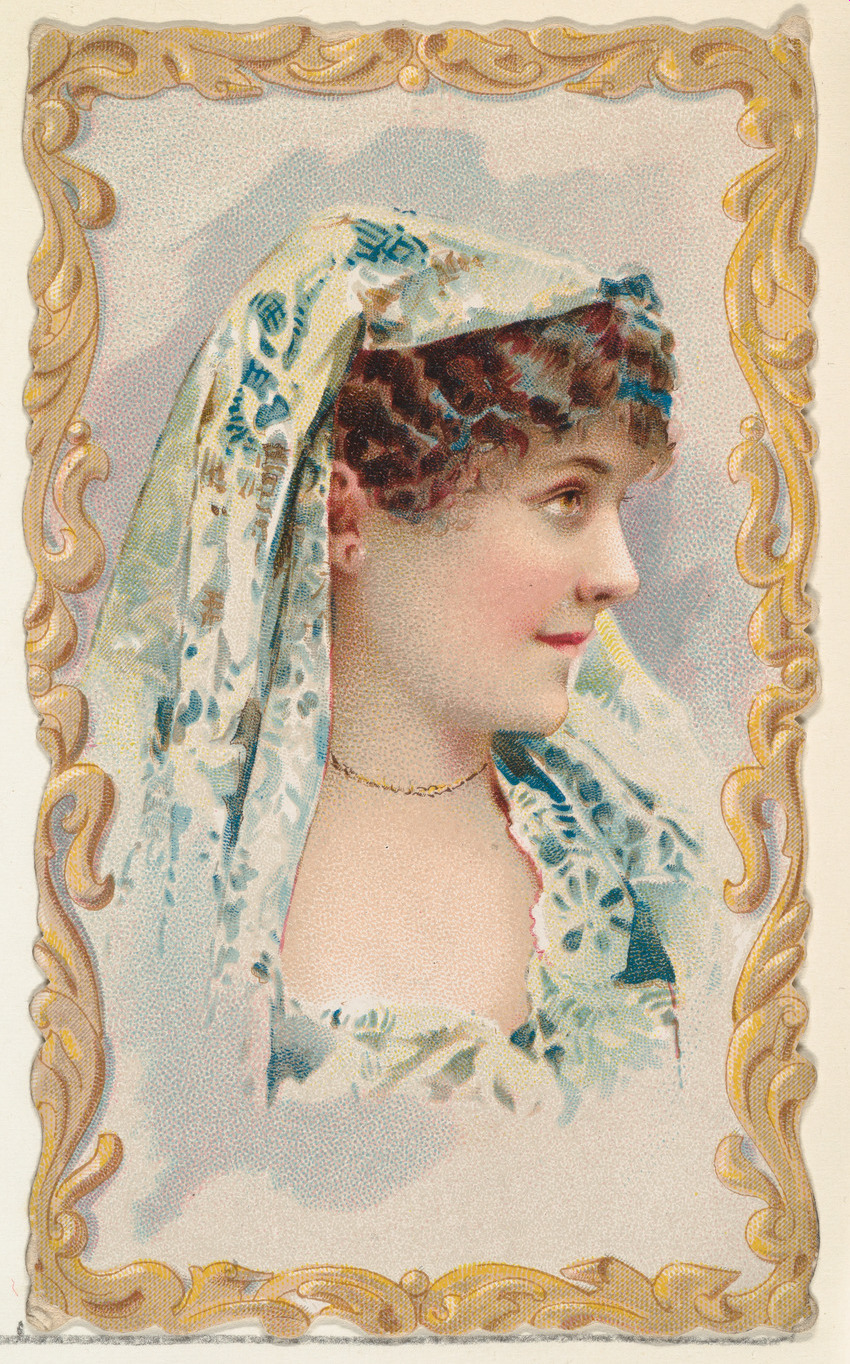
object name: print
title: Picture Frame, from the Novelties series (N122) issued by Gail & Ax Tobacco to promote Navy Long Cut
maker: gail & ax tobacco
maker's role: publisher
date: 1889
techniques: color lithograph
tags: profiles,women